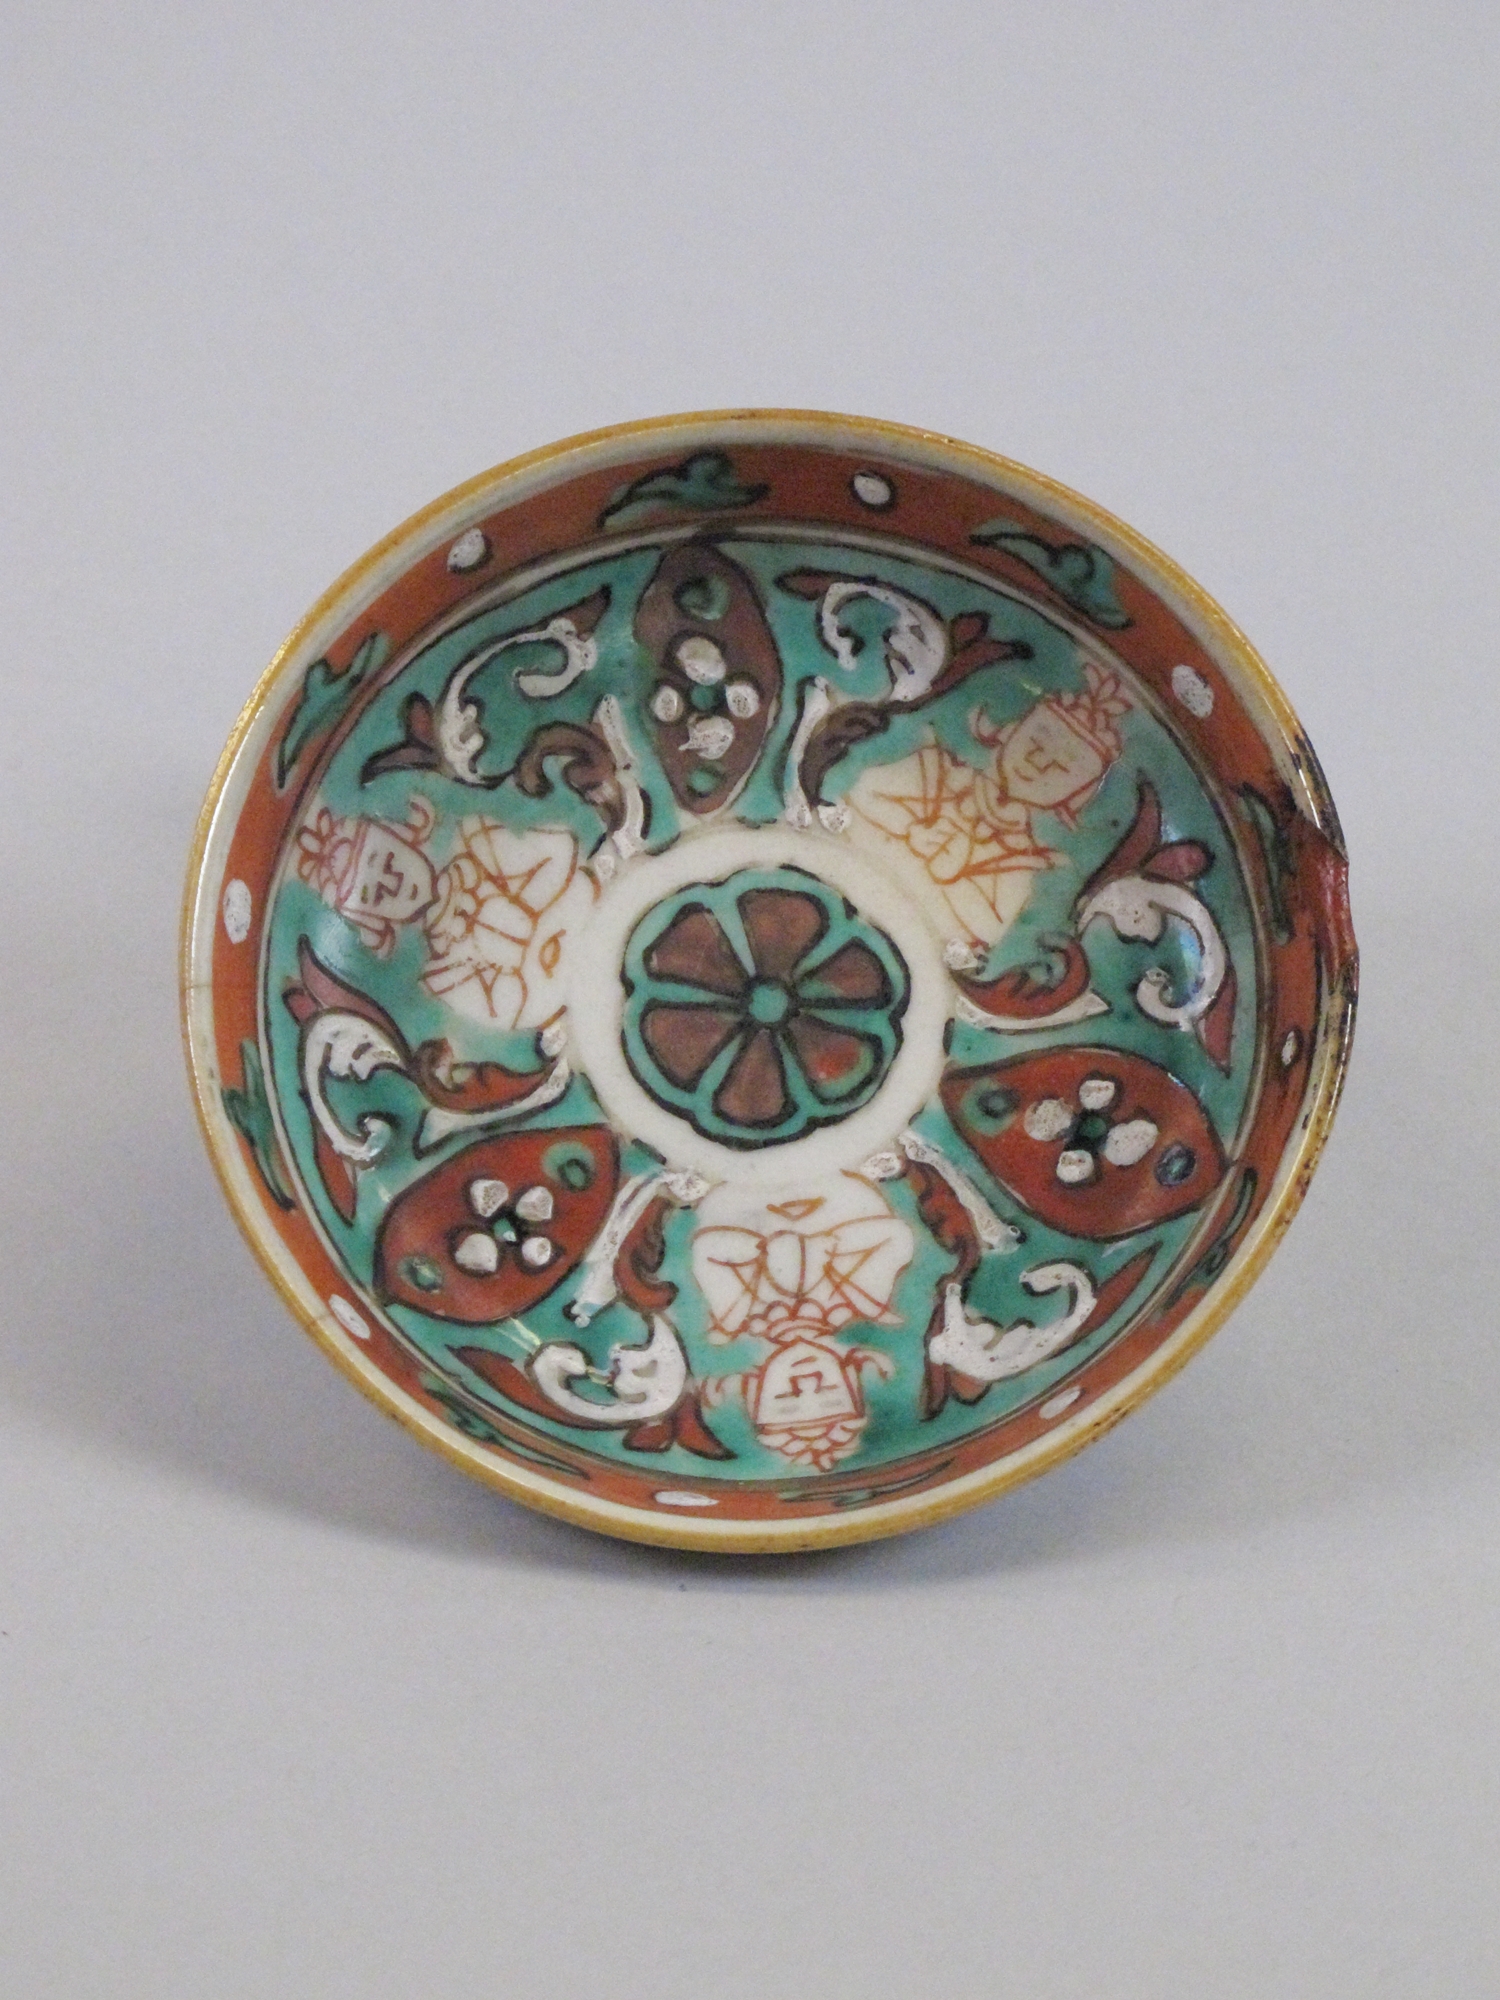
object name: saucer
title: Saucer with Thai mythical figures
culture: chinese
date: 1801-1900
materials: enamel, porcelain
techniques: overglaze, painting, polychrome